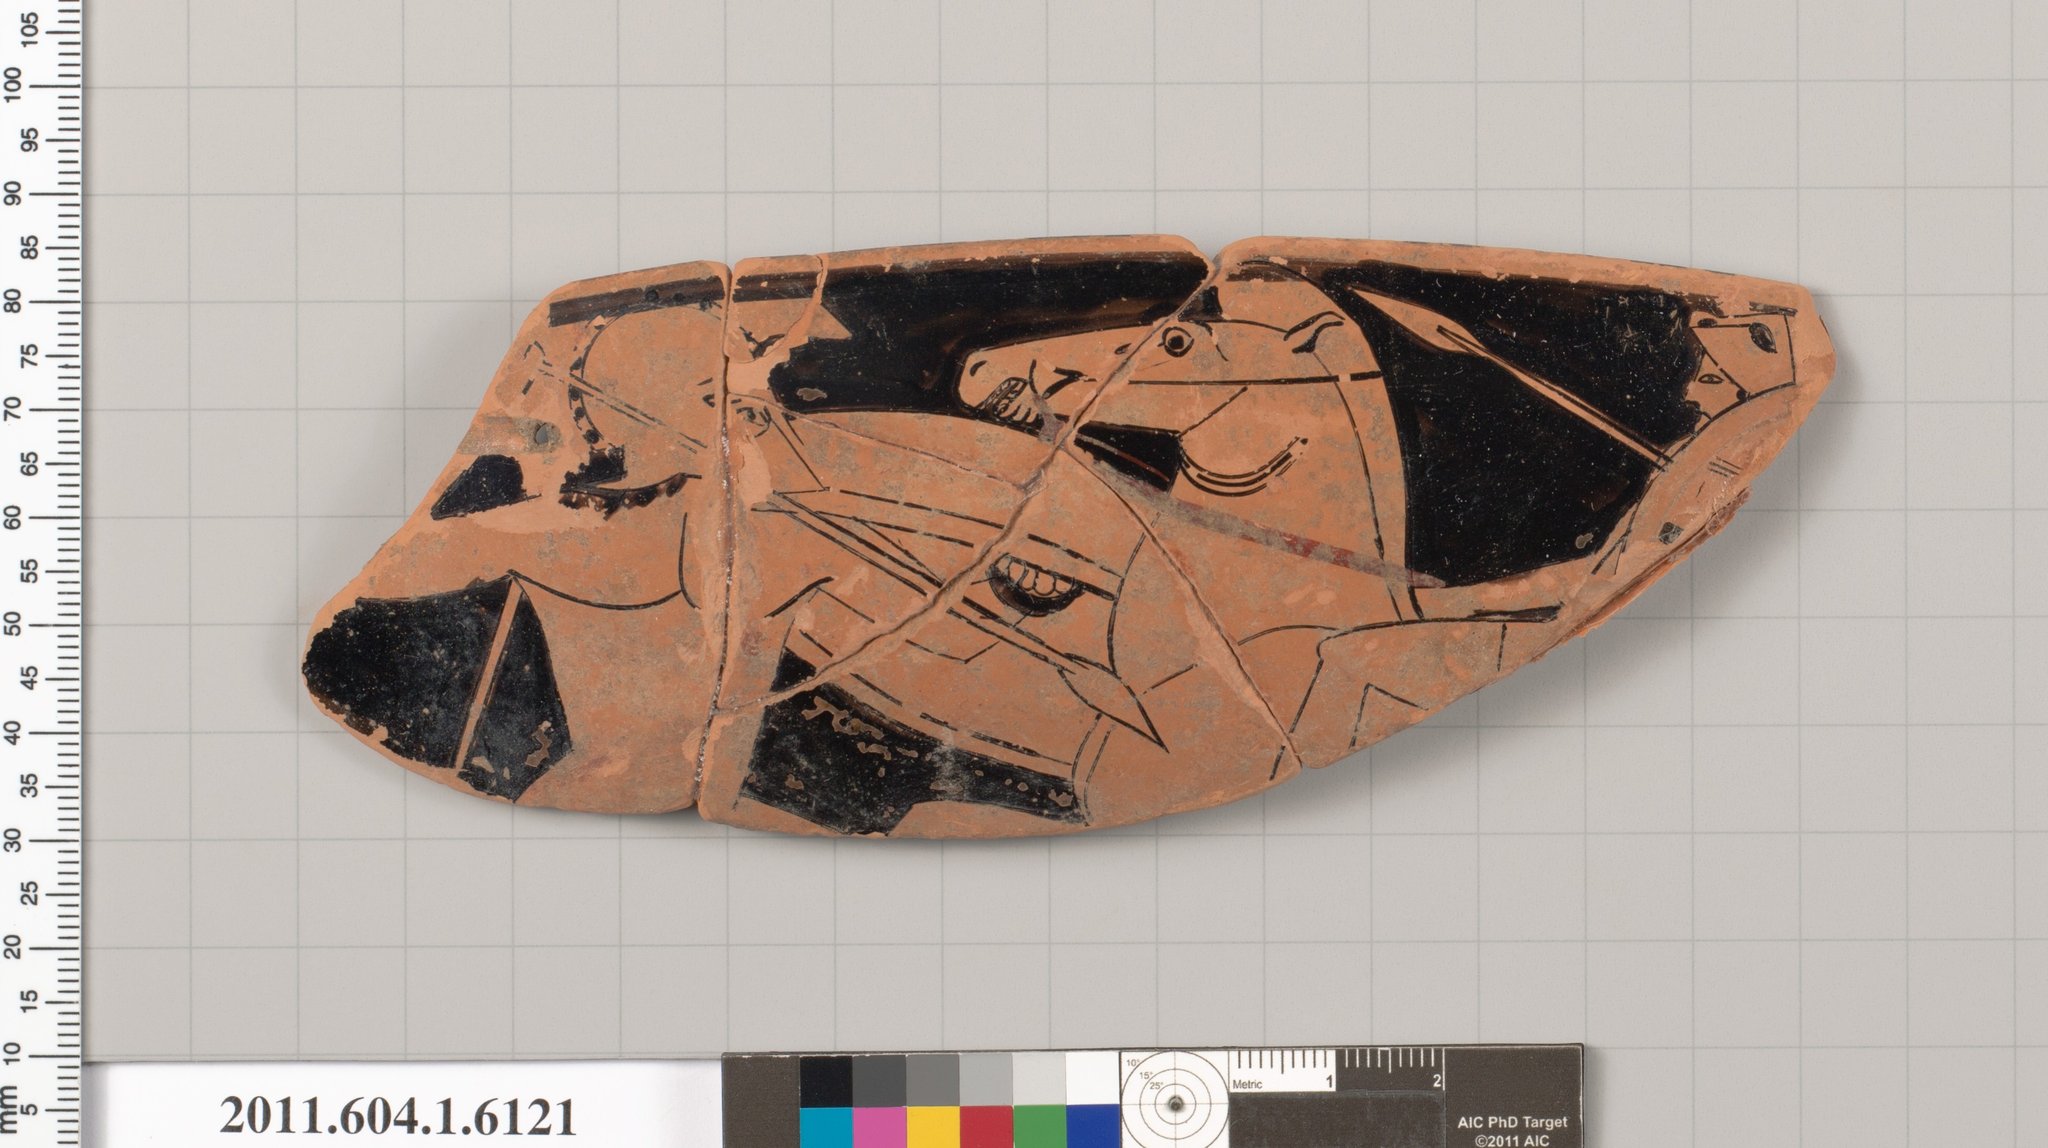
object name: kylix fragment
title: Terracotta rim fragment of a kylix (drinking cup)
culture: greek, attic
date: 520-500 BCE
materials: terracotta